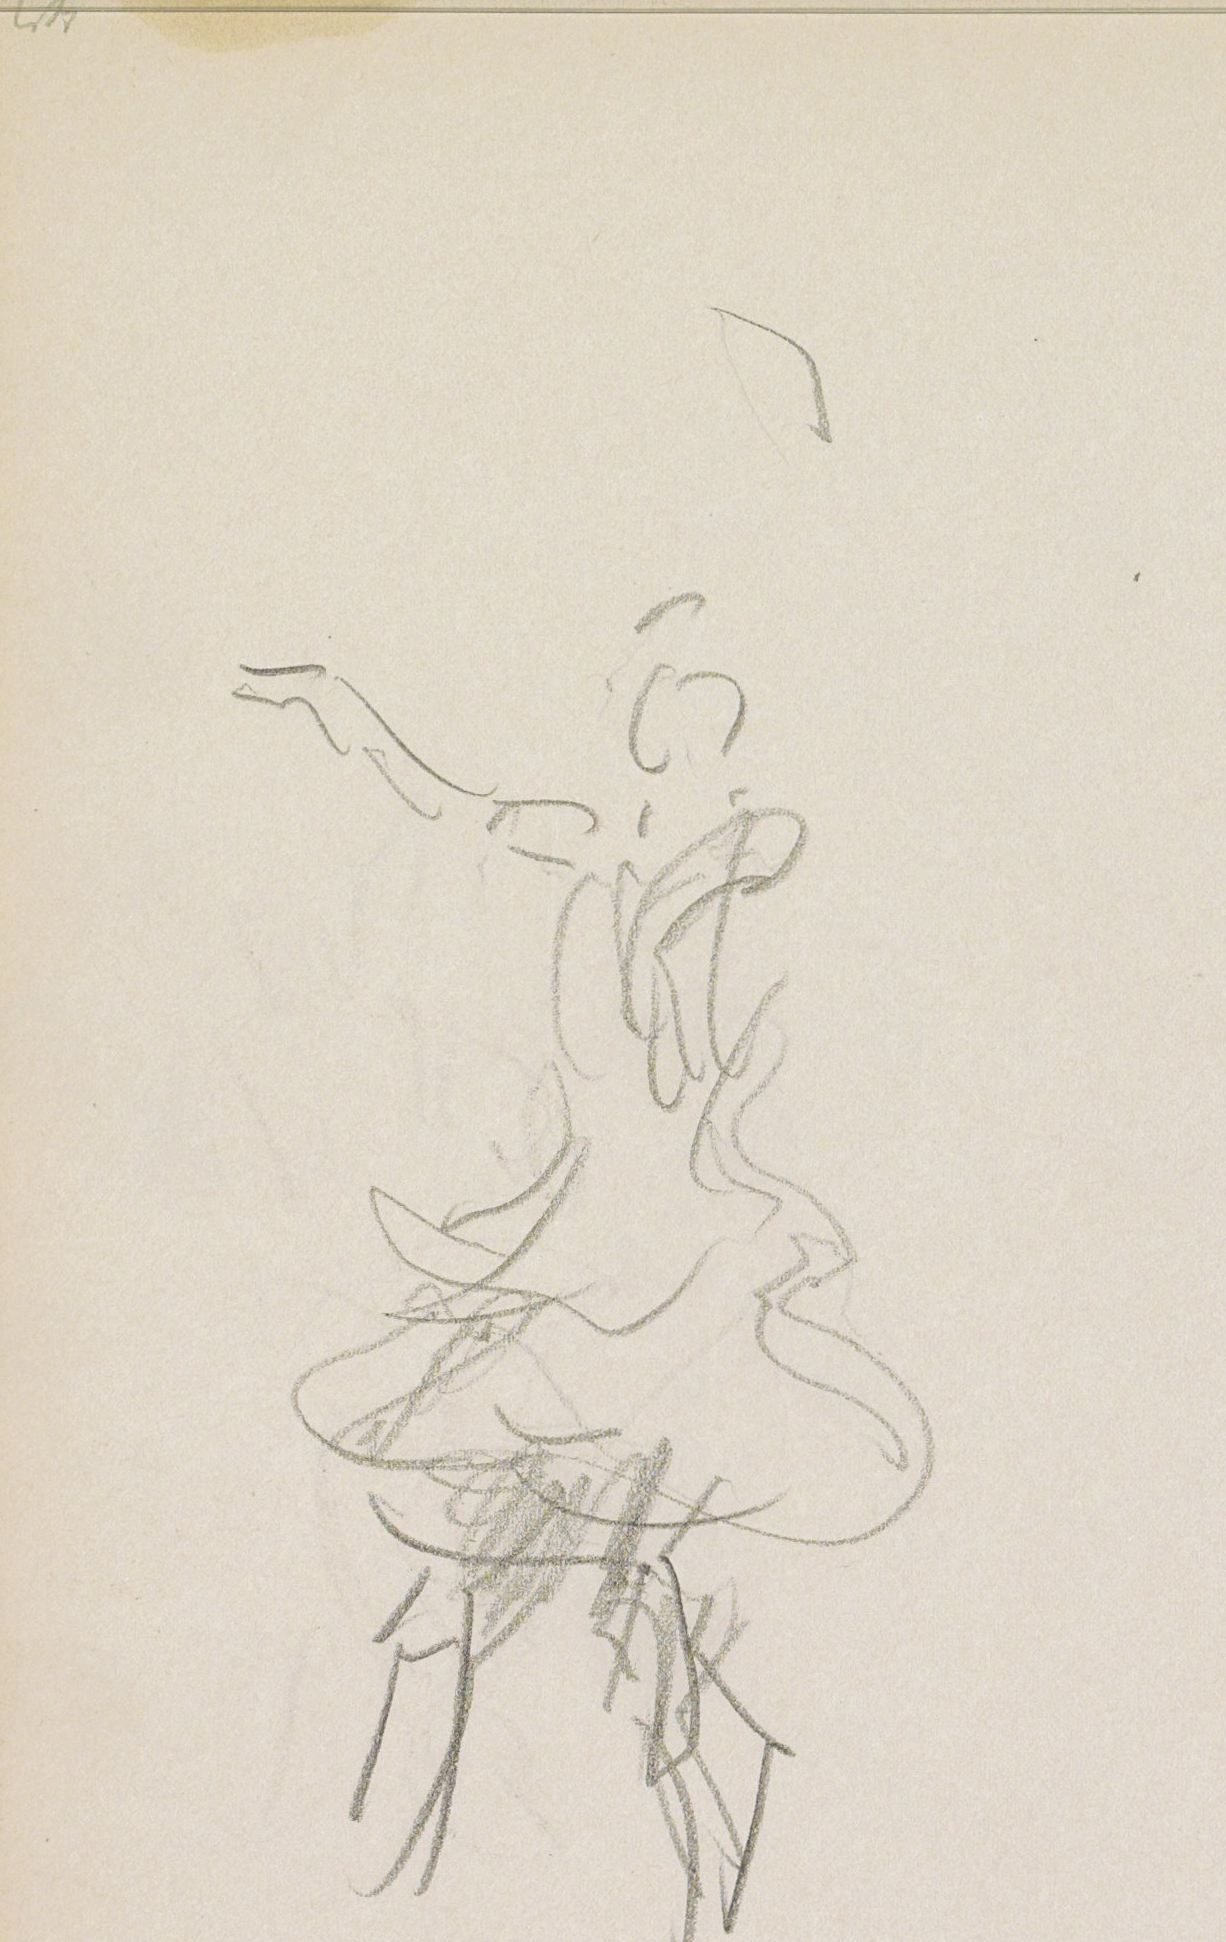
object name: sketchbook leaf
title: Vrouw in een jurk, mogelijk een danseres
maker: isaac israels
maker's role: draughtsman, painter, print maker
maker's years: 1865-1934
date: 1875-1934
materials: paper, pencil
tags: female dancer, dress, gown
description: Blad 40 verso uit schetsboek LII met 43 bladen.